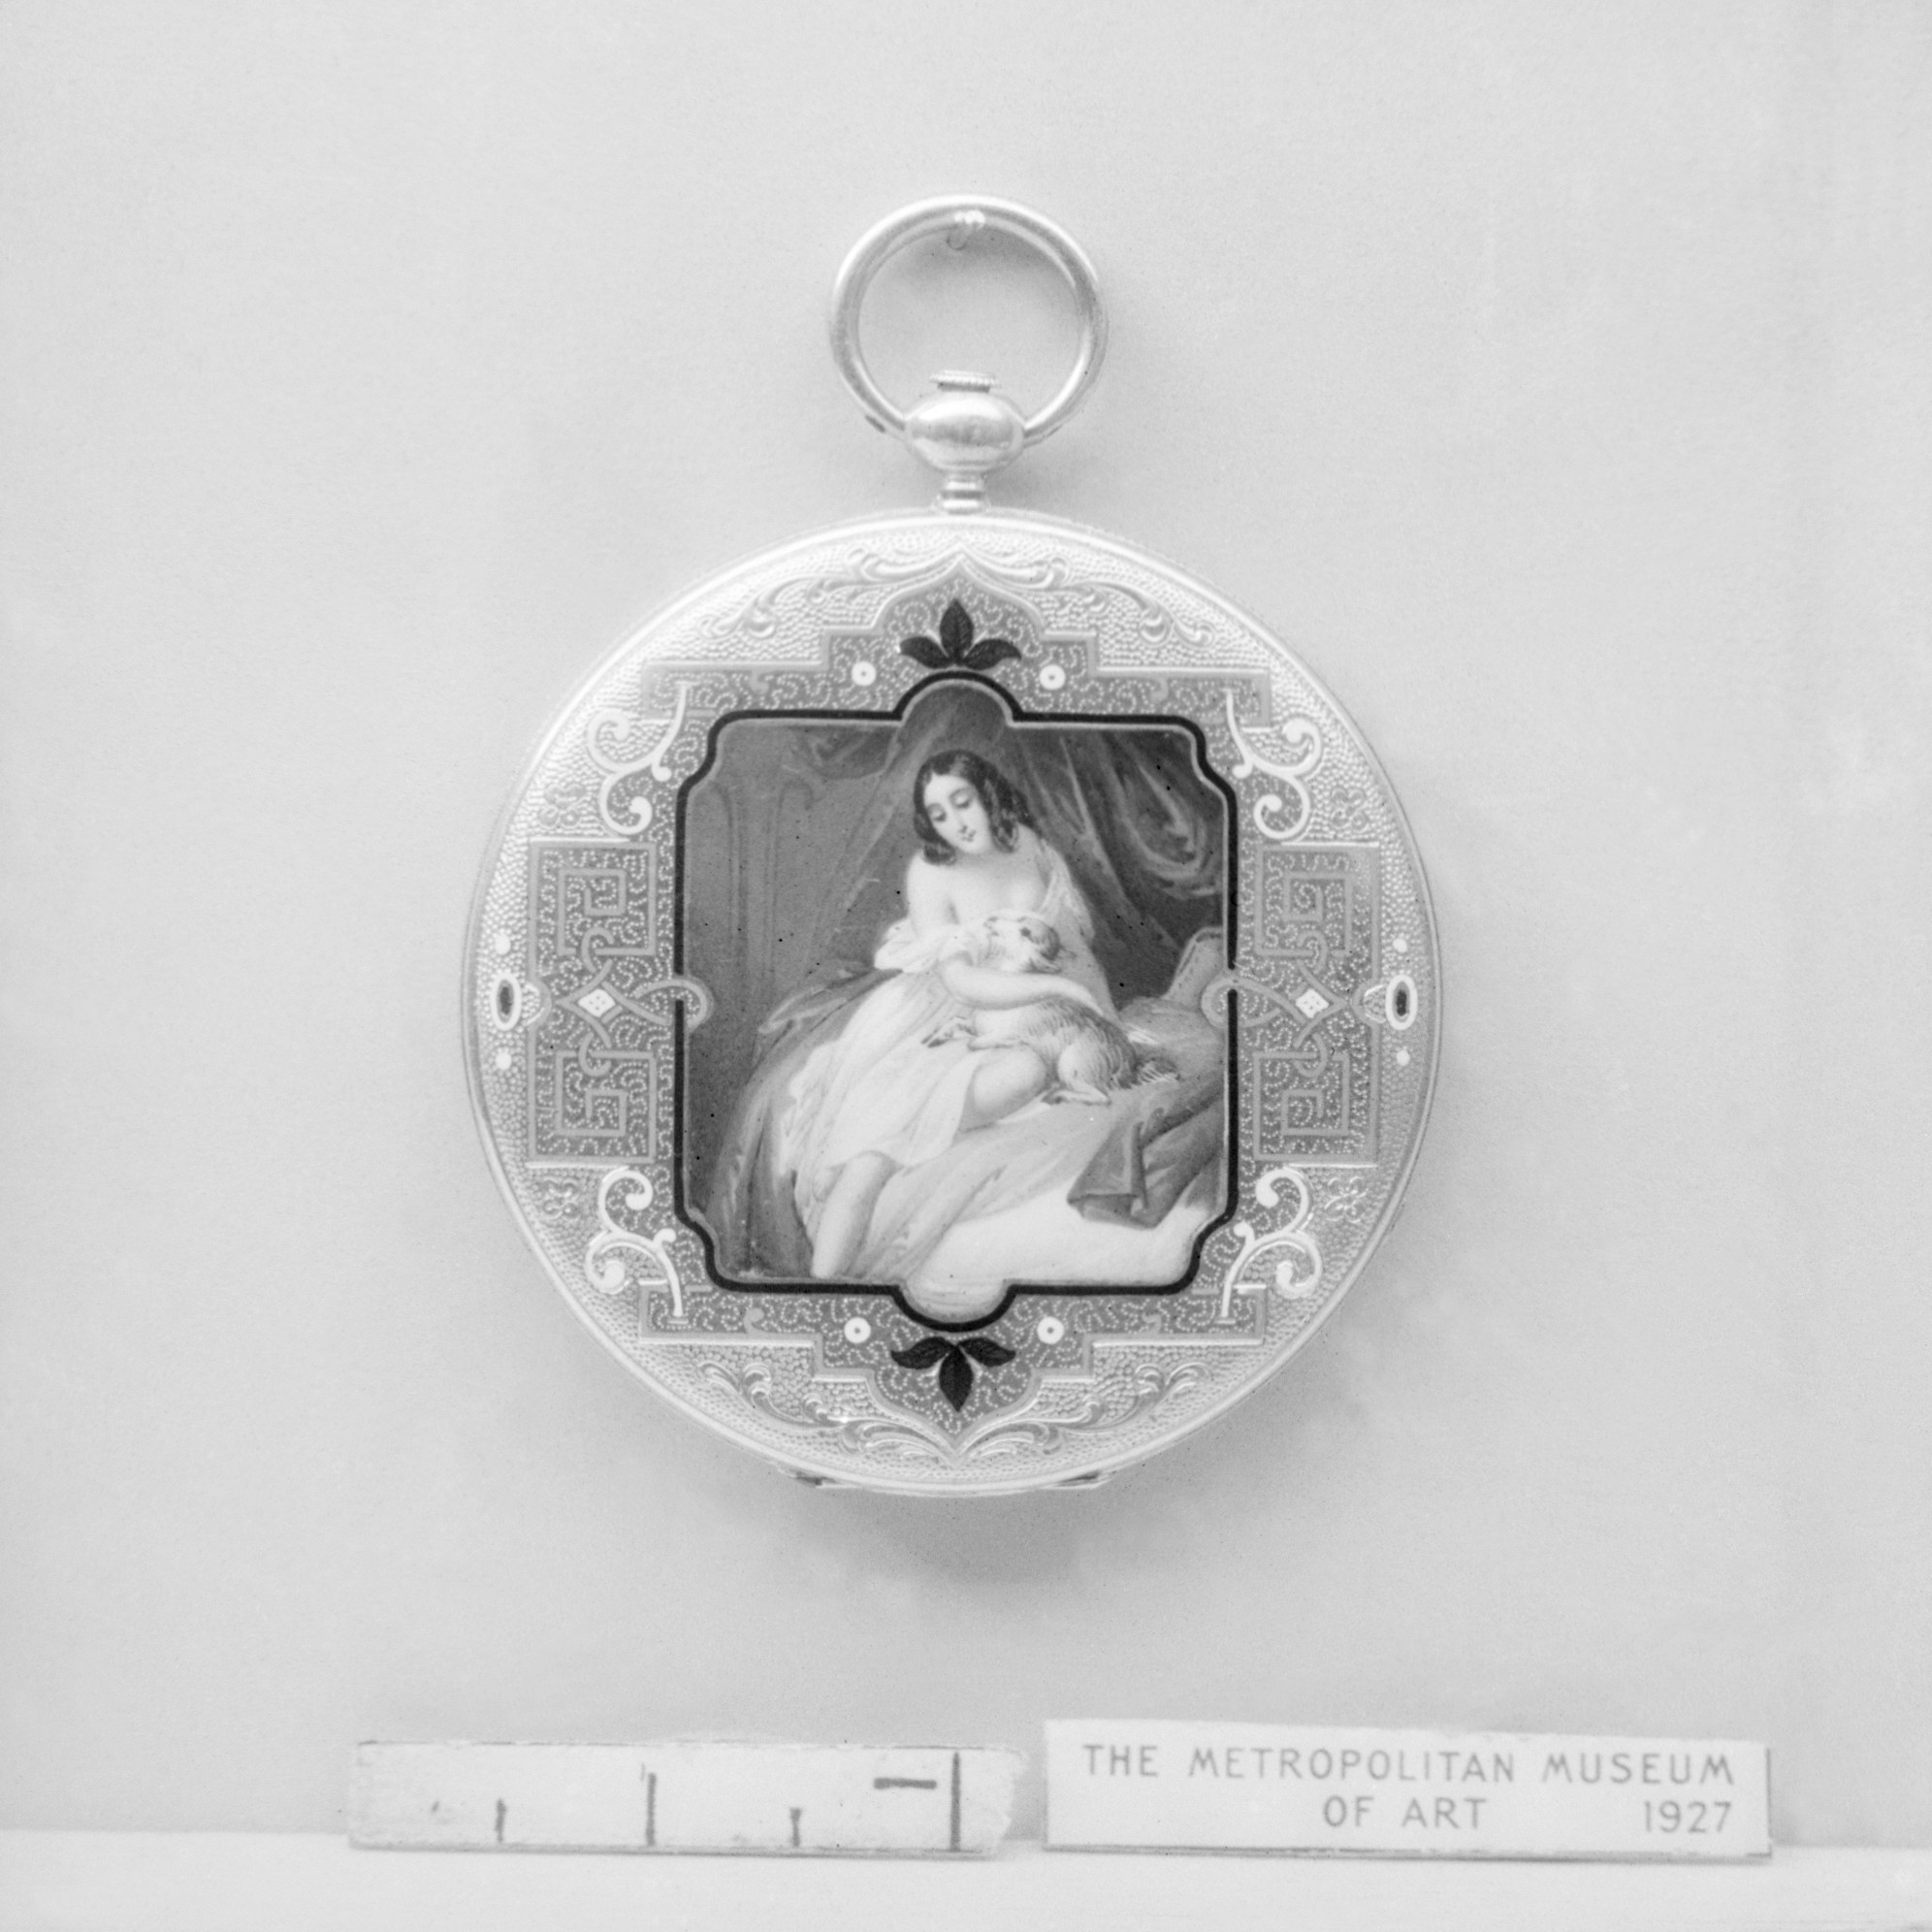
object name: watch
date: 1801-1900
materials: enamel, gold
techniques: enamel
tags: women,lambs